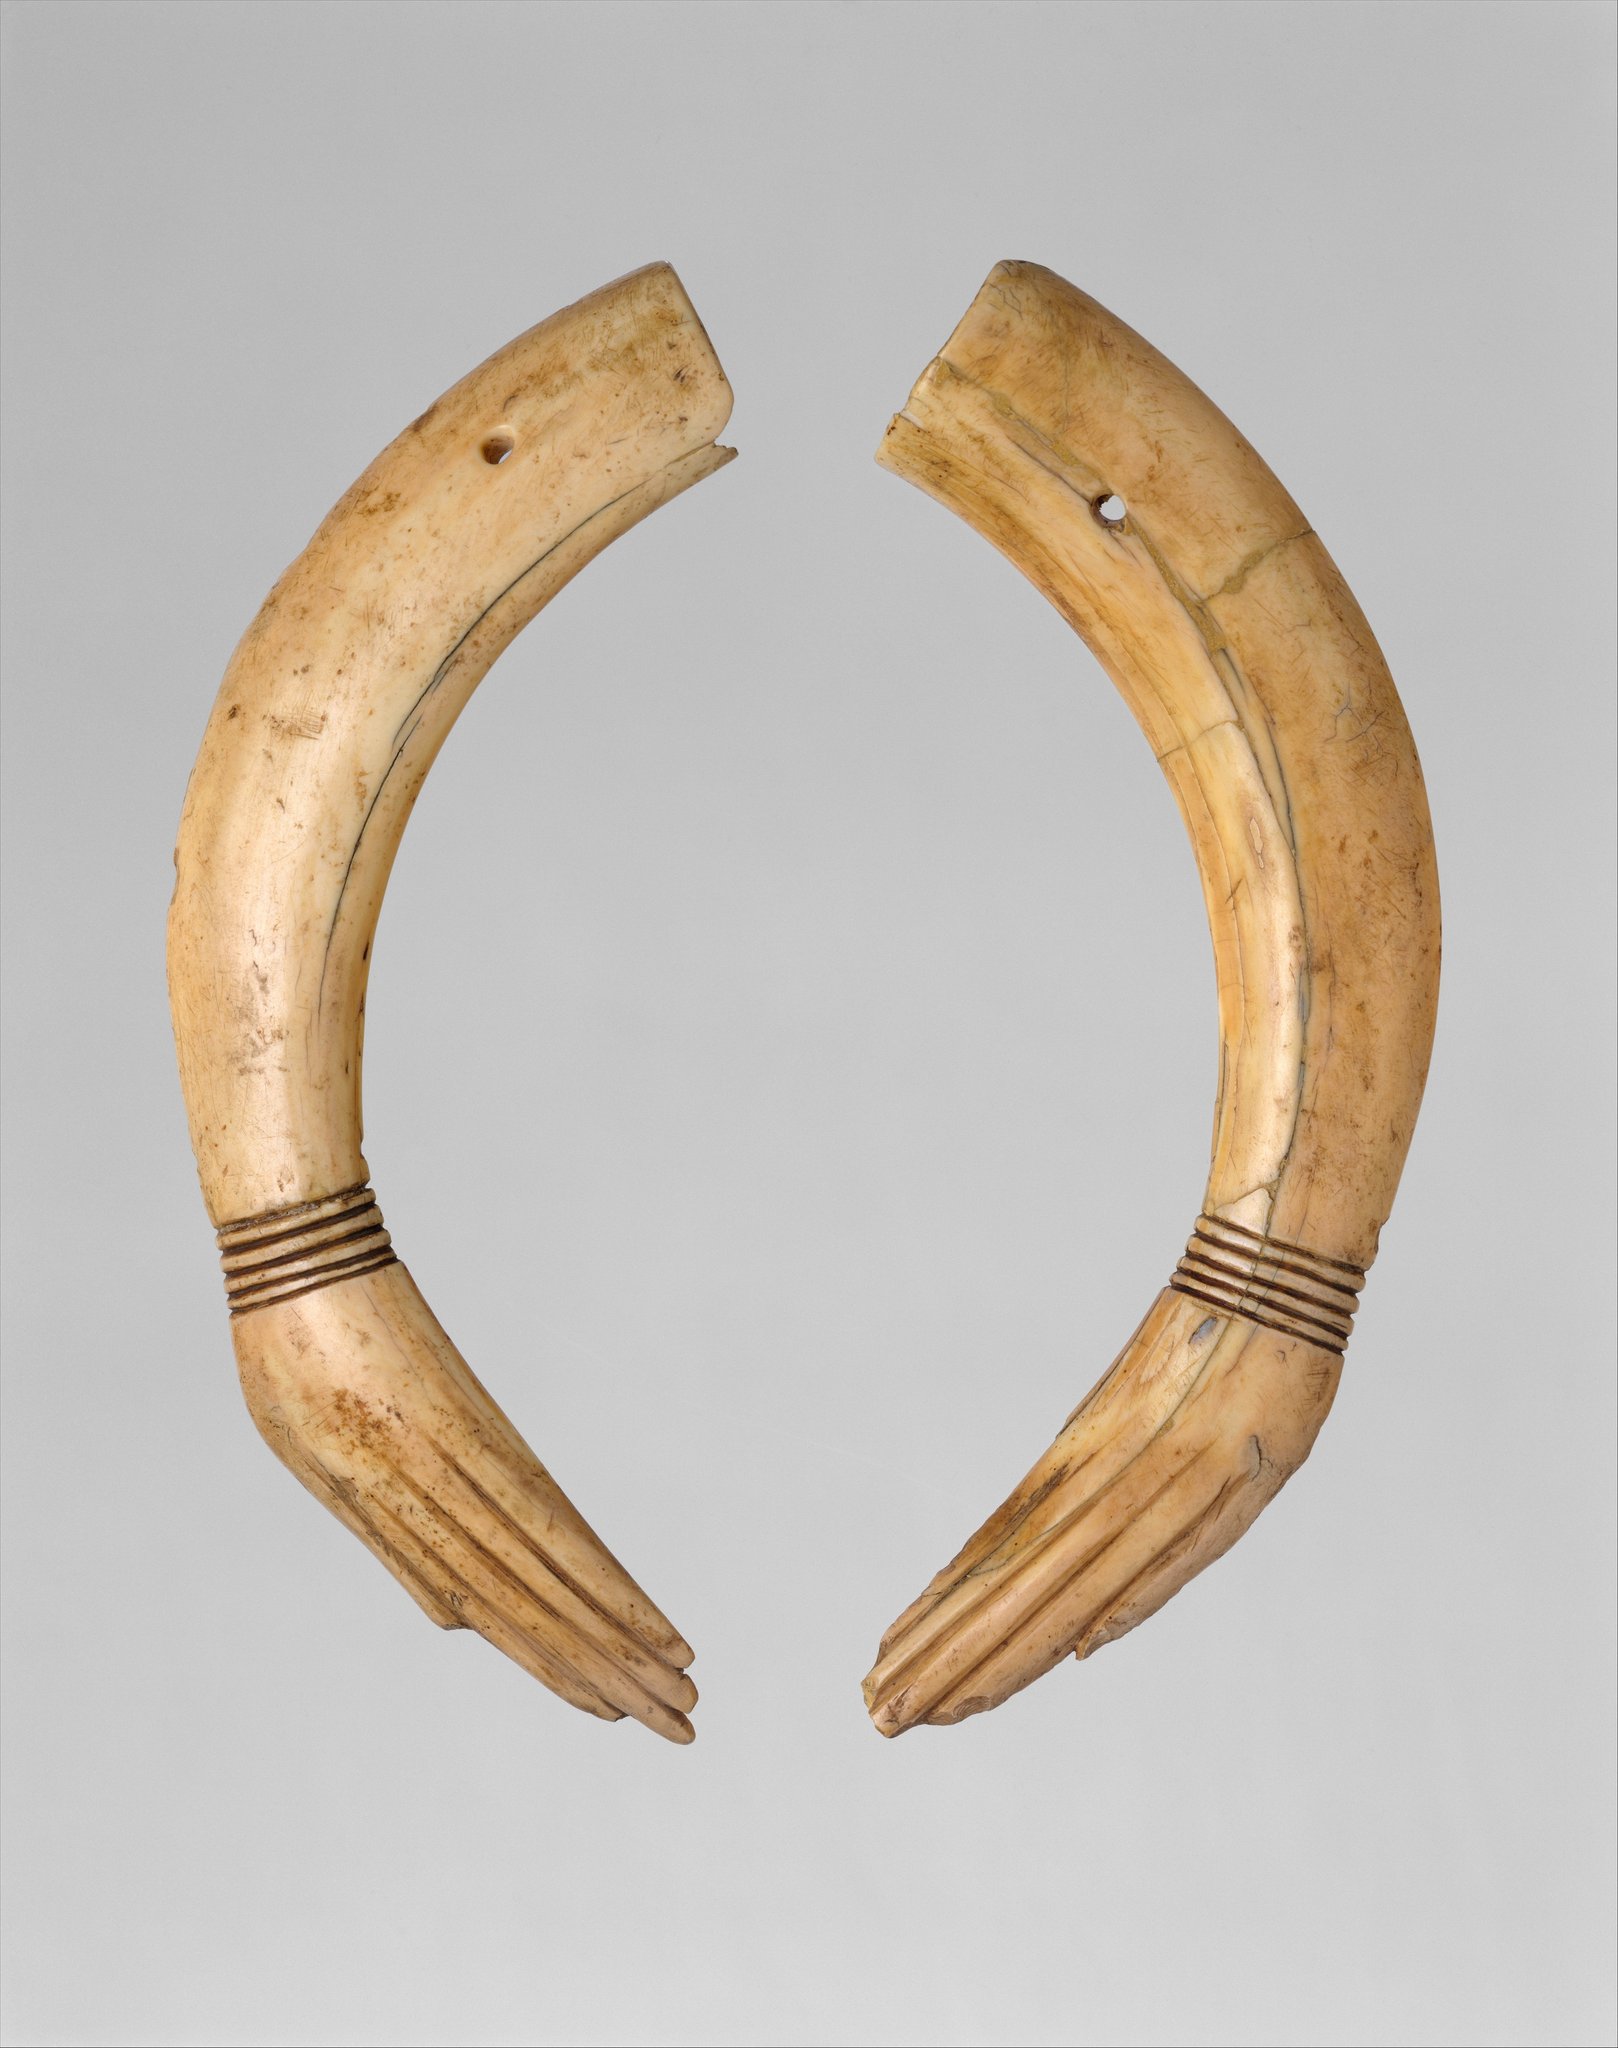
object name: music, clapper, arm, hand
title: Pair of Clappers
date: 1353-1336 BCE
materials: ivory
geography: egypt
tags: musical instruments,hands